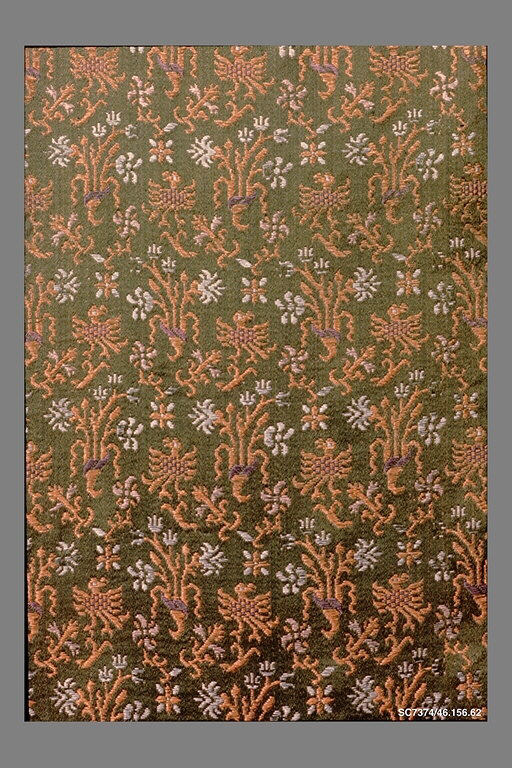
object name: panel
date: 1601-1633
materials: silk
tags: eagles,flowers